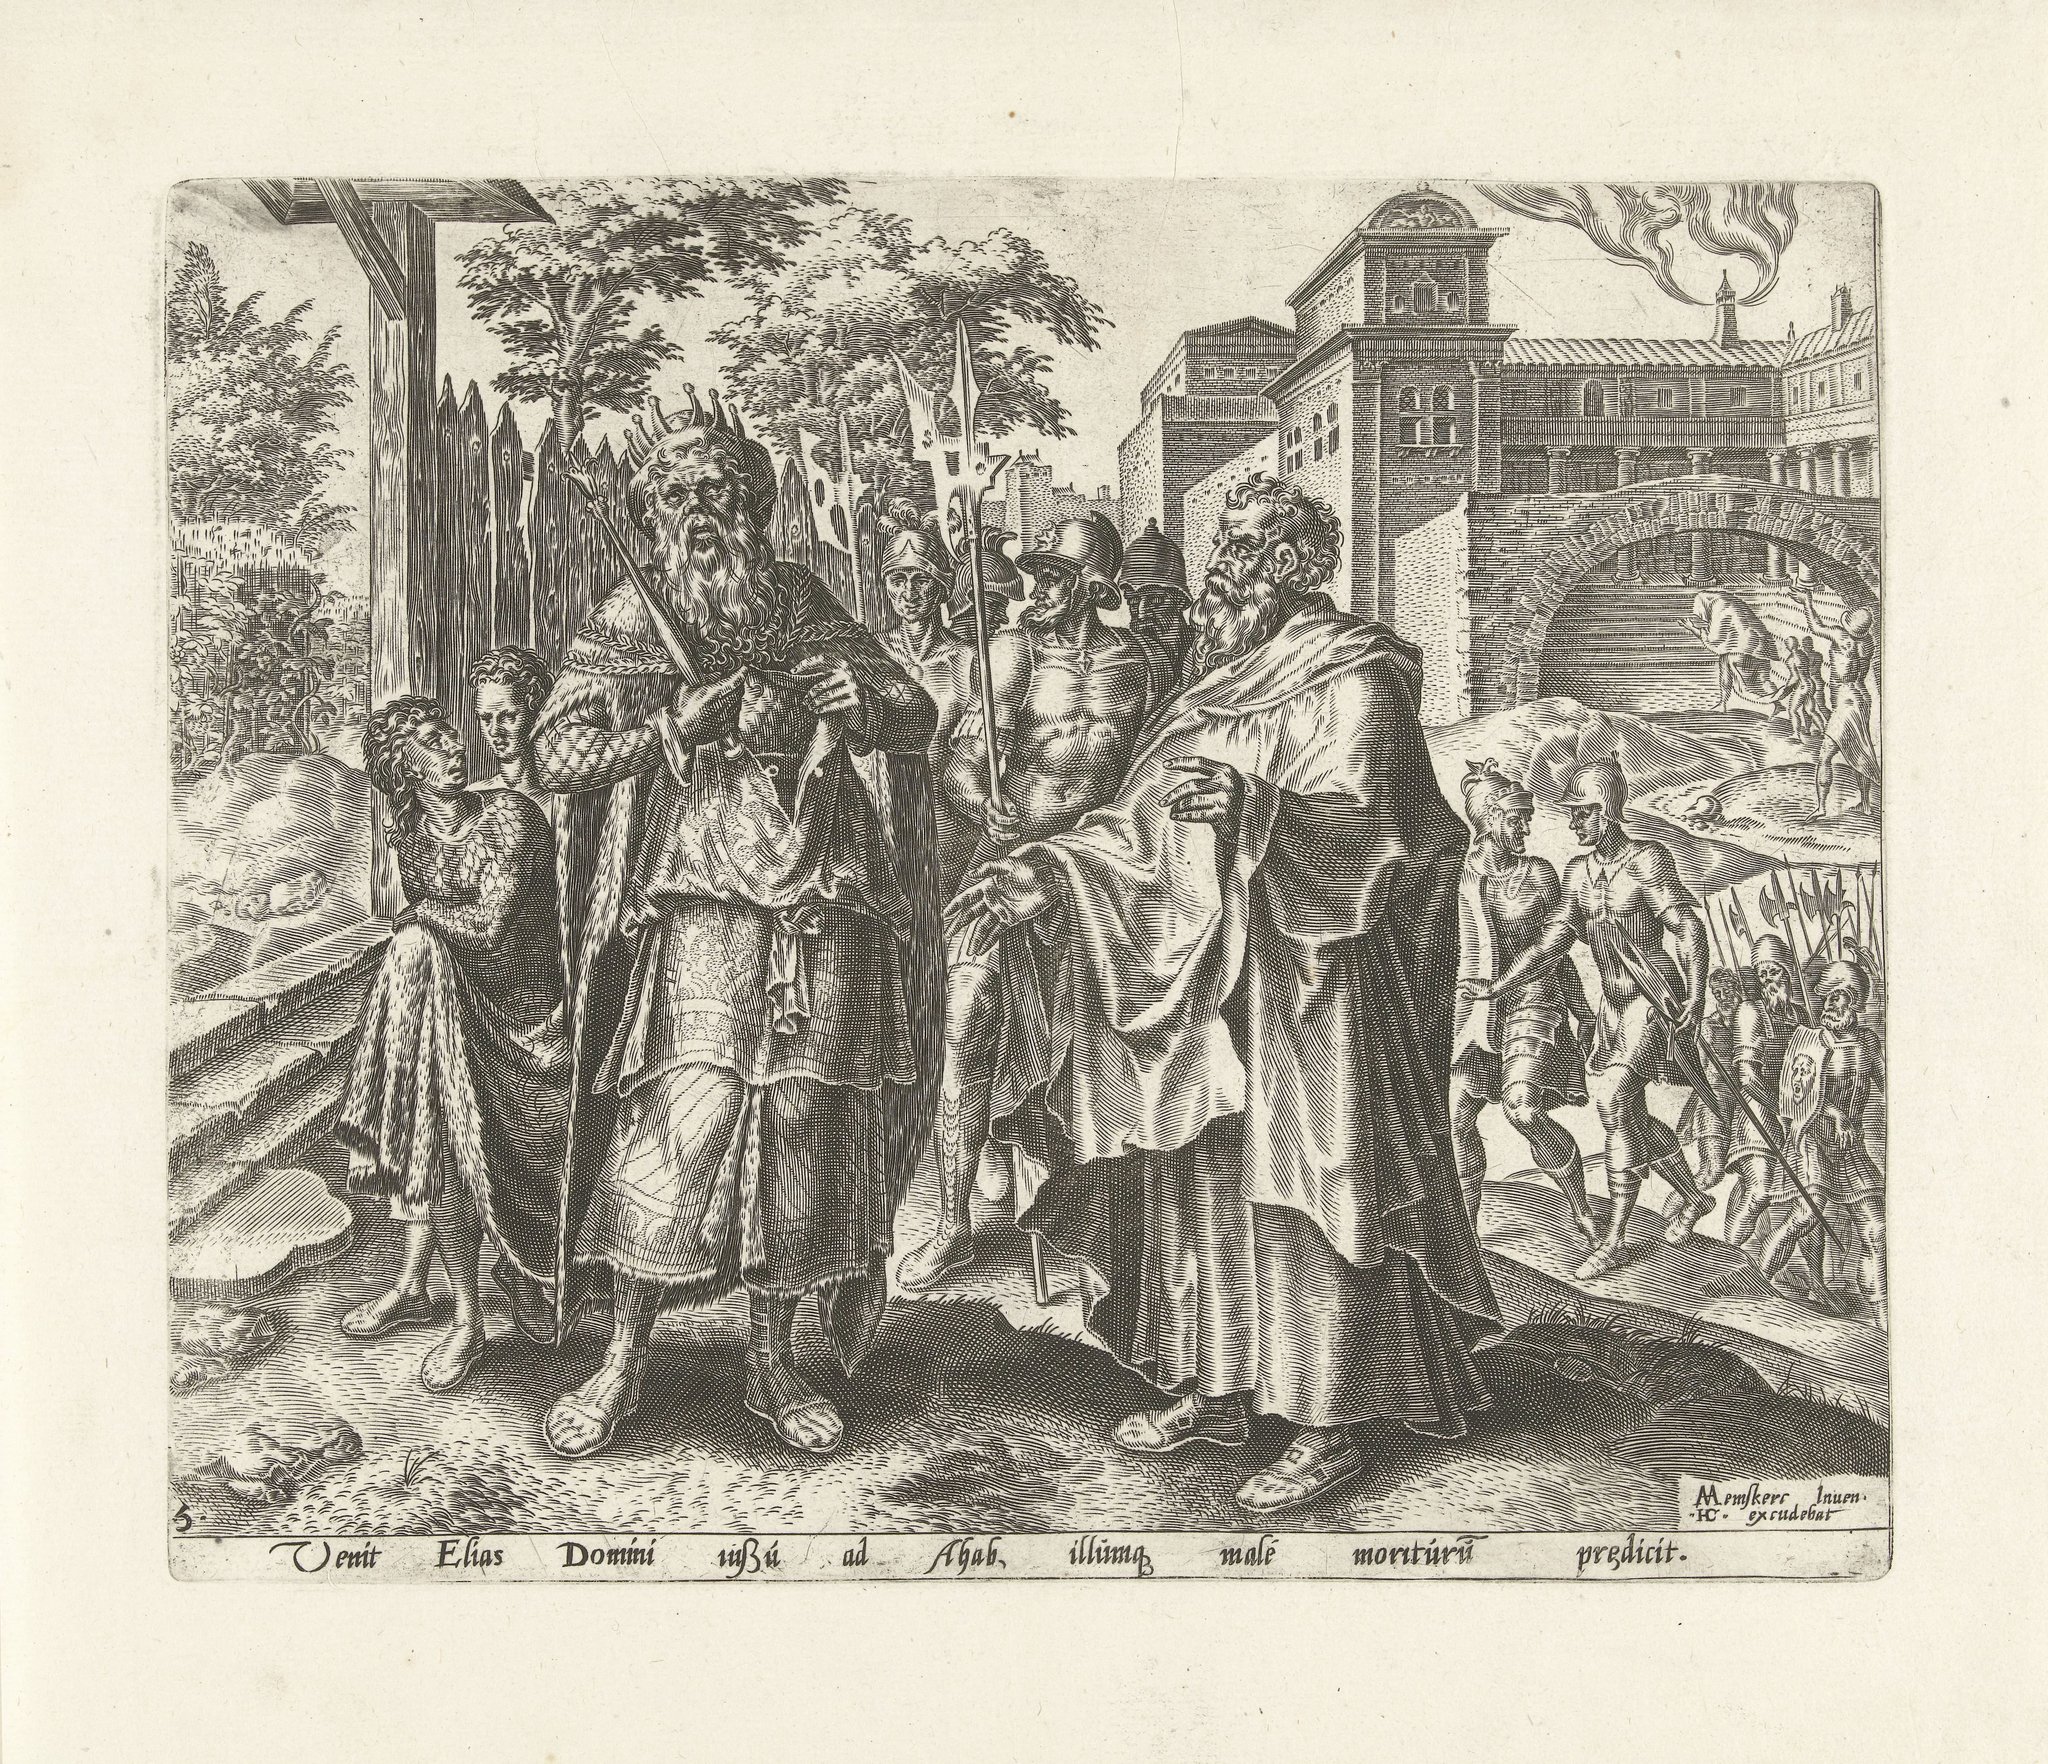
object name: print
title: Geschiedenis van Achab en Nabot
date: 1561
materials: paper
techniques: engraving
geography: antwerp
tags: ahab repentant: he tears his clothes, puts sackcloth on and refuses food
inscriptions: collector's mark: Lugt 2228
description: Elia spreekt een vloek uit over Achab en zijn hele familie. Achab toont berouw en verscheurt meteen zijn mooie kleren en trekt een boetekleed aan. Achab en Elia staan buiten de muren van Achab's paleis bij de wijngaard van Nabot.